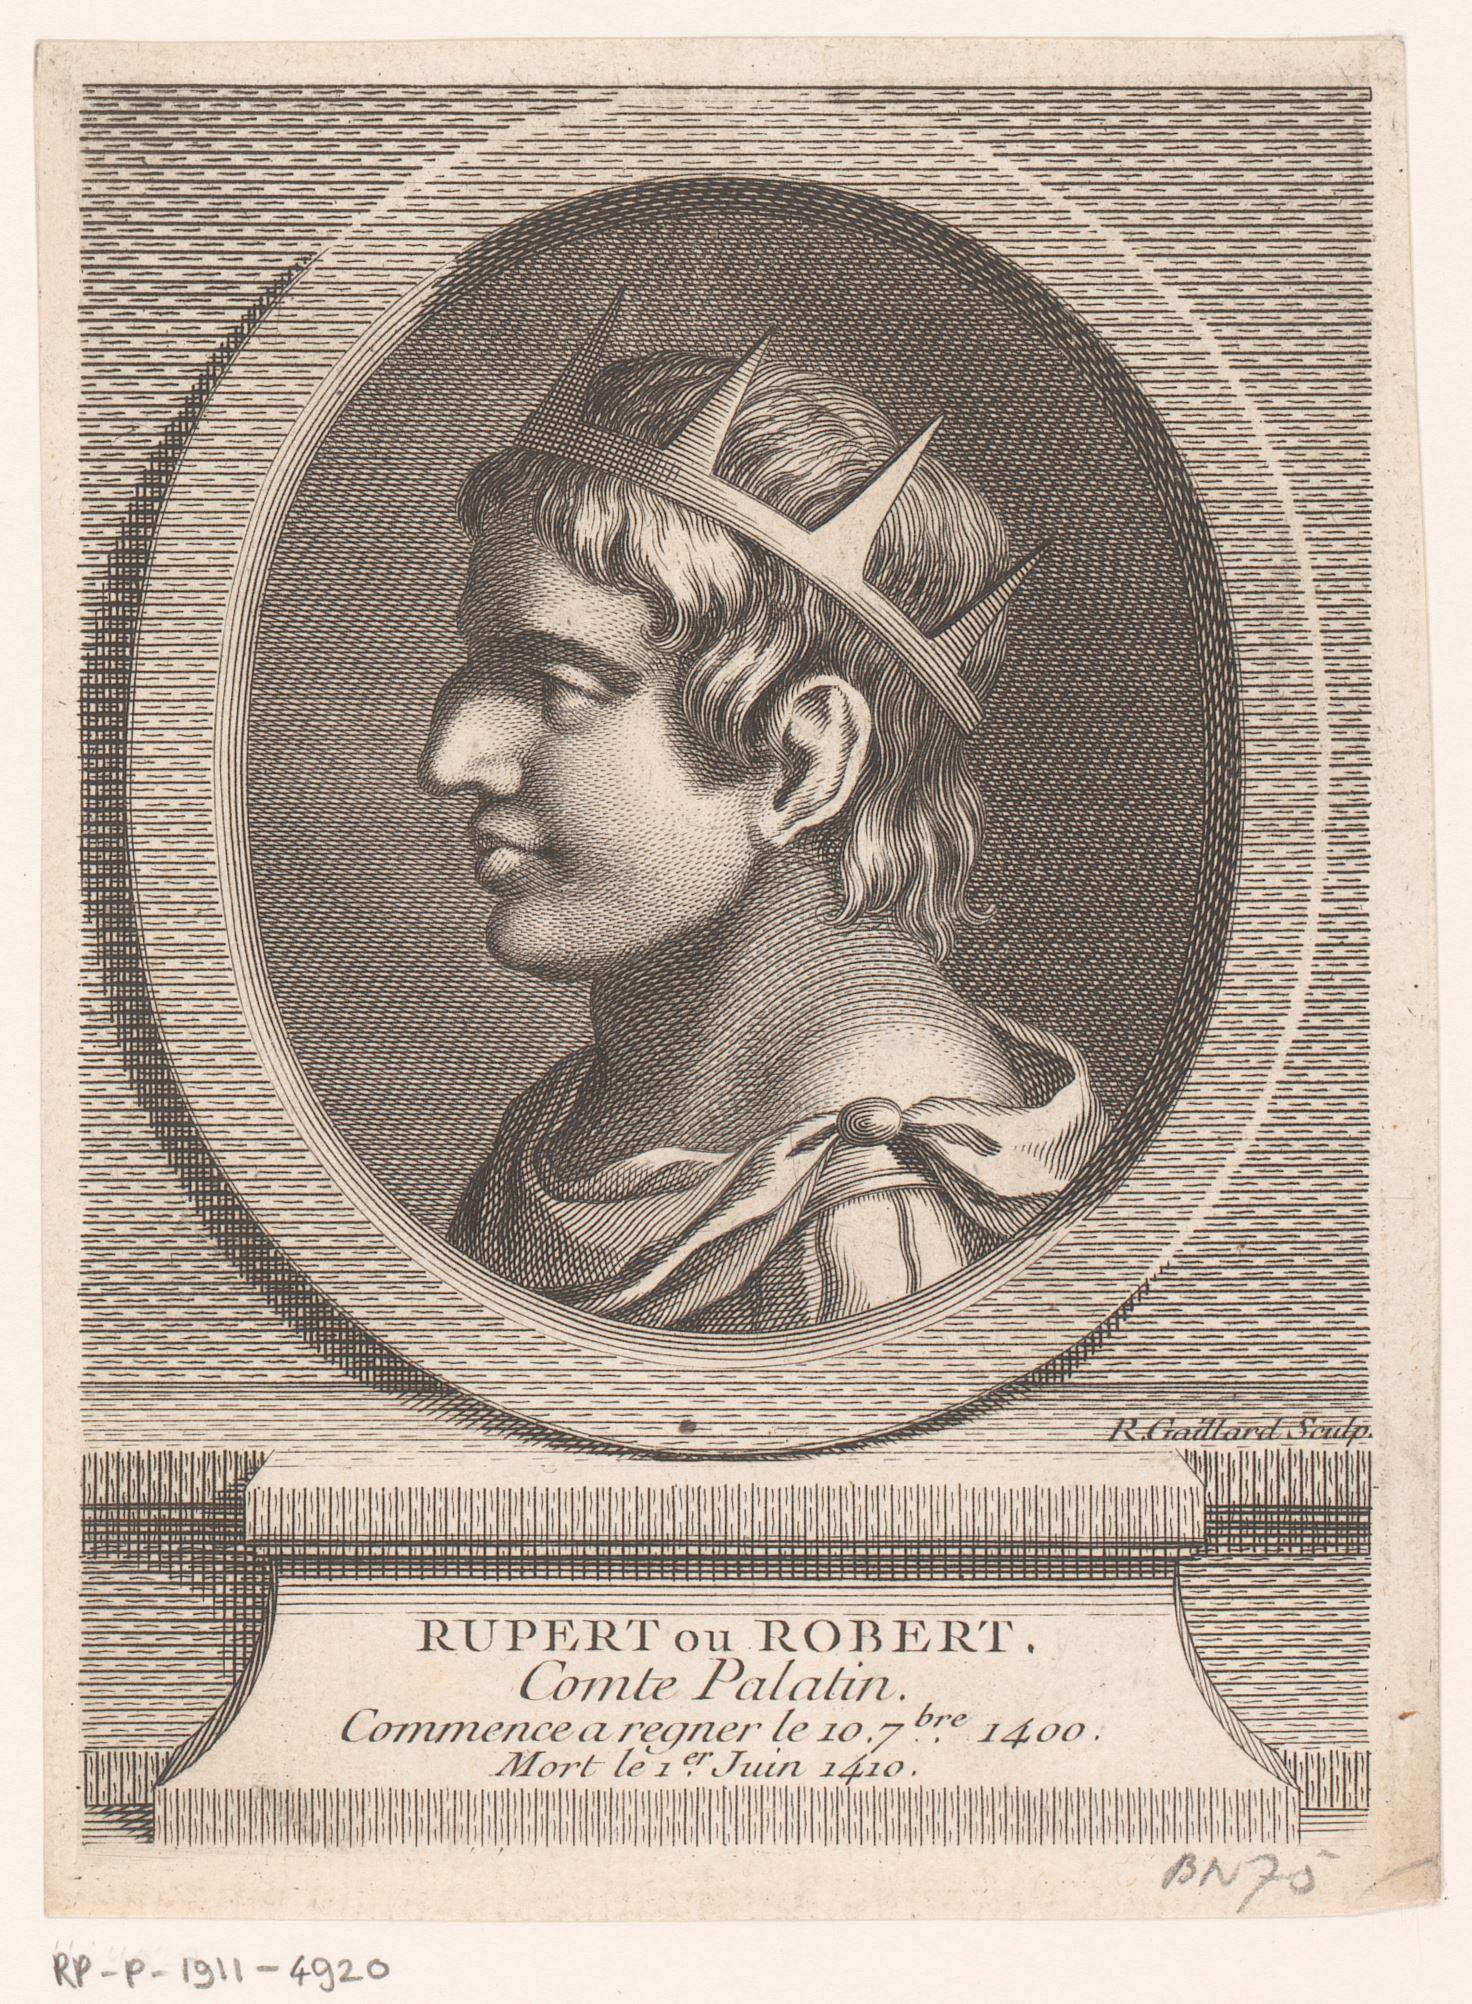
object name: book illustration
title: Portret van Ruprecht van de Palts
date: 1755-1765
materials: paper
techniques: engraving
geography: paris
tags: amberg, historical persons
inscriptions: collector's mark: Lugt 2228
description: Mogelijk prent uit: Dreux du Radier, Jean-François. L'Europe illustré, contenant l'histoire abregée des souverains, des princes, des prélats, des ministres, (...) en Europe: dans le XVe. siècle compris, jusqu'à présent. Parijs: Michel Odieuvre en André-François Le Breton, 1755-1765, dl. 1.